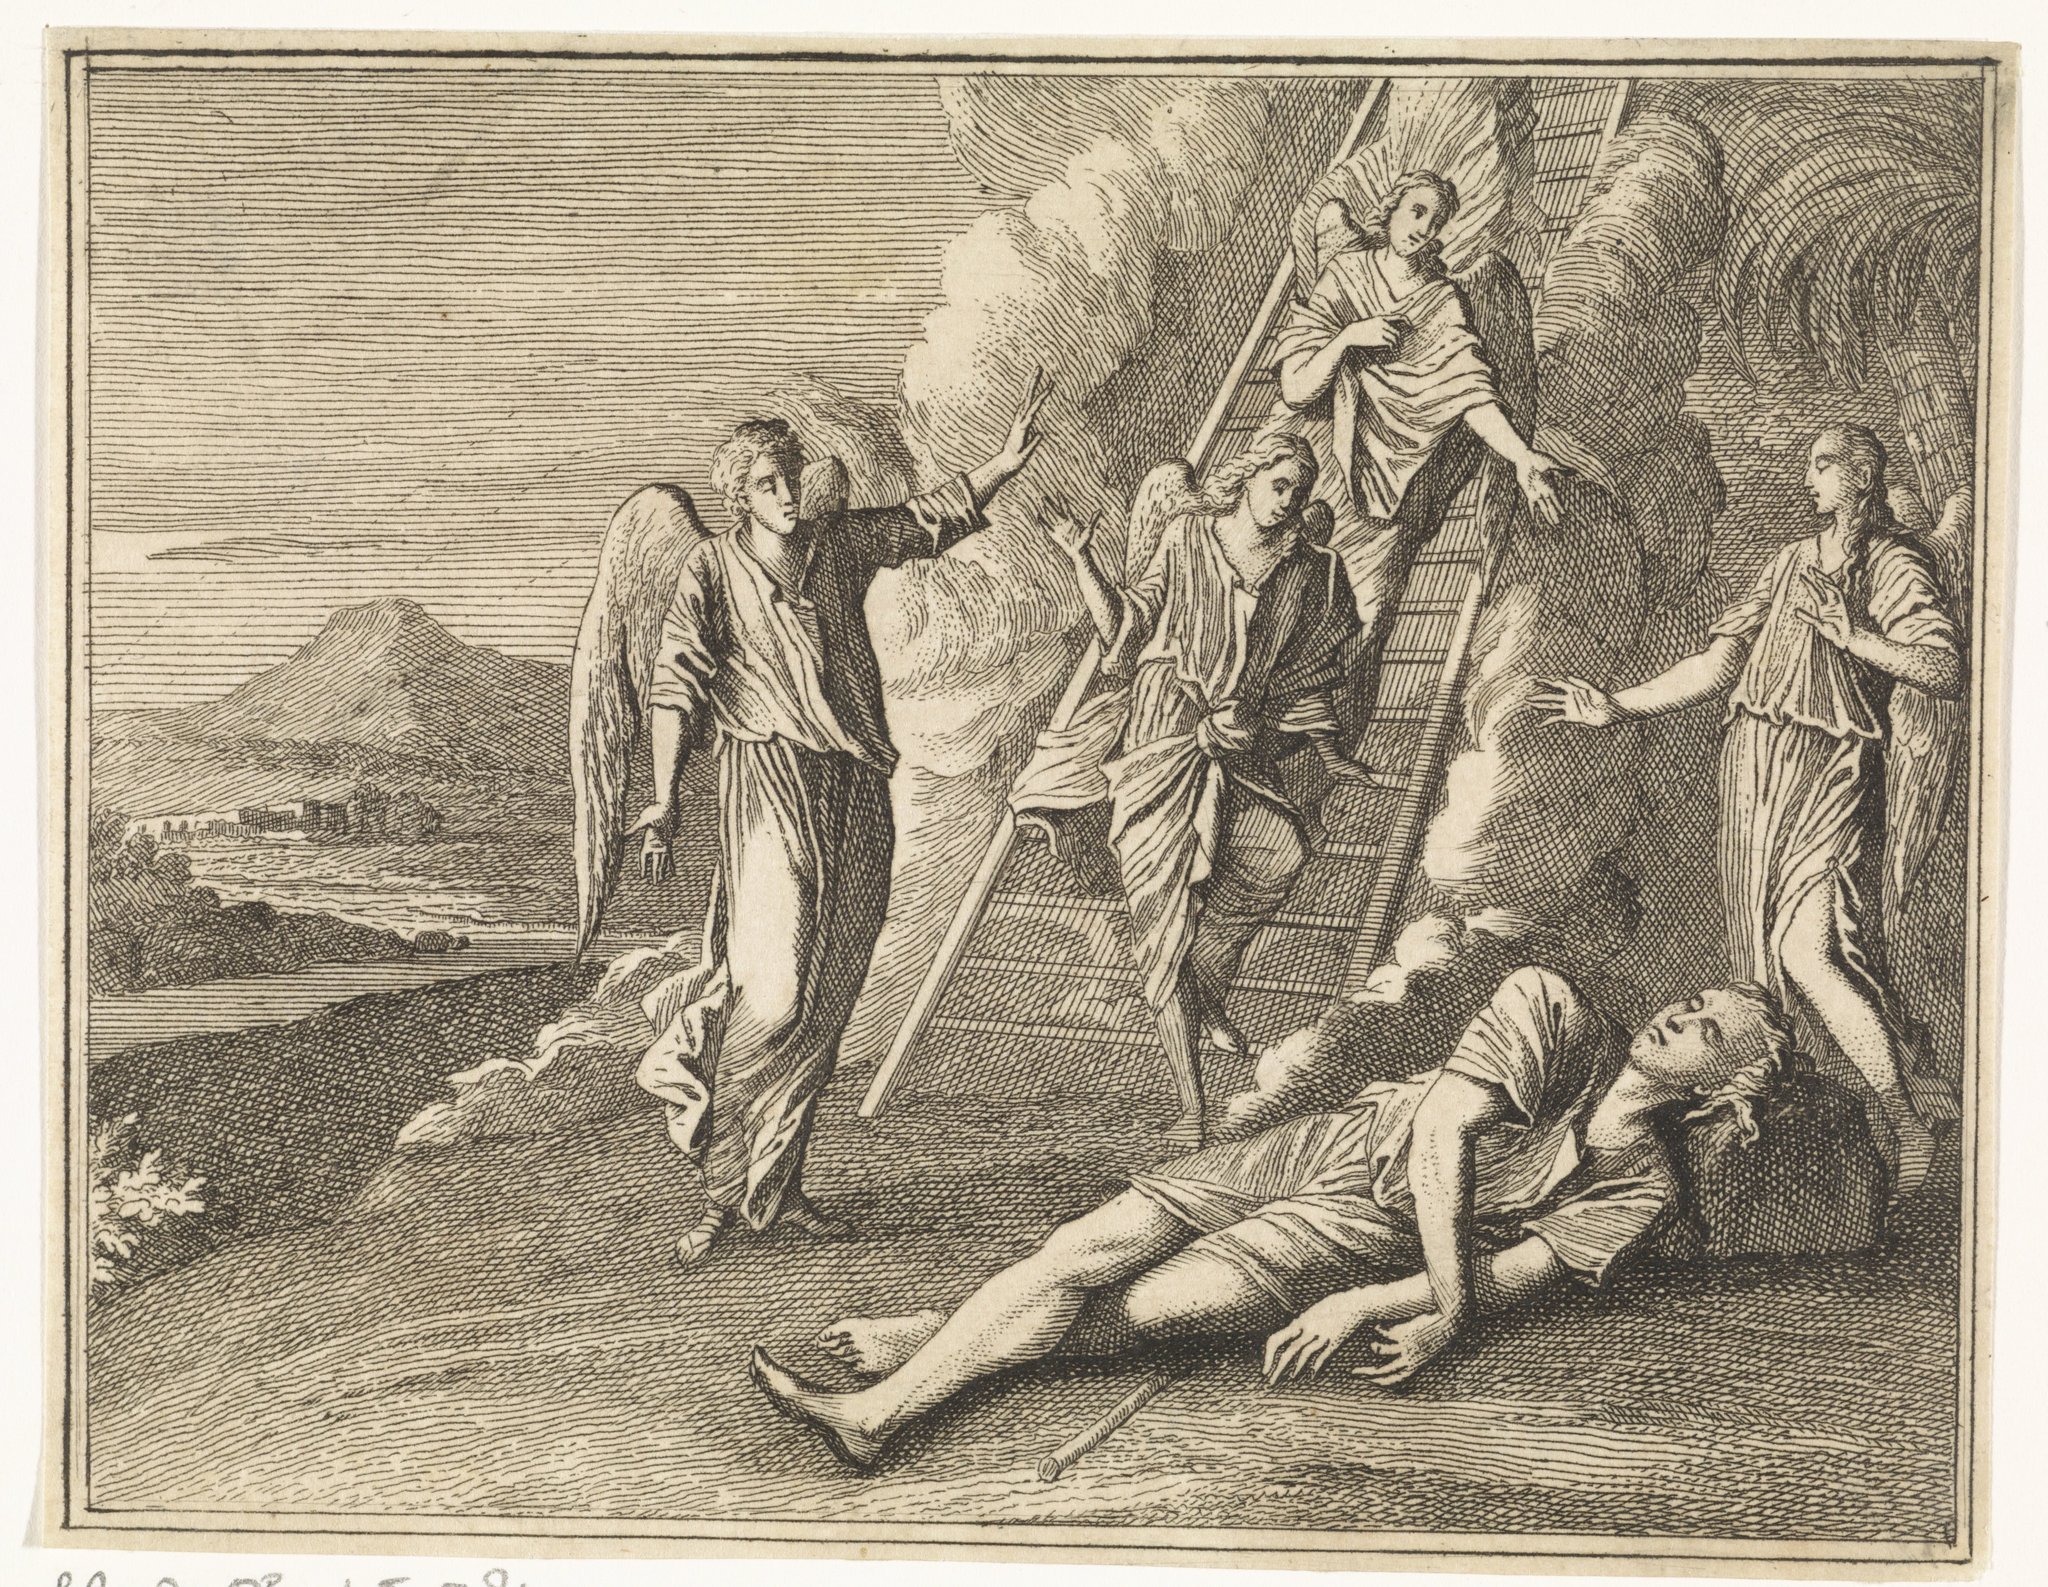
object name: print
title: Droom van Jakob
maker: caspar luyken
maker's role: draughtsman, print maker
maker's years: 1672-1708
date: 1712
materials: paper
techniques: etching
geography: amsterdam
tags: the dream of jacob: while sleeping on the ground with a stone for pillow jacob sees a ladder reaching from earth to heaven with angels going up and down; usually with god at the top of the ladder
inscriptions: collector's mark: Lugt 2228, number: ‘30’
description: Illustratie uit: Luyken, Jan. De schriftuurlyke geschiedenissen en gelykenissen van het Oude en Nieuwe Verbond, 2 delen. Amsterdam: Wed. Pieter Arentsz II en Cornelis van der Sys, 1712, dl. I.